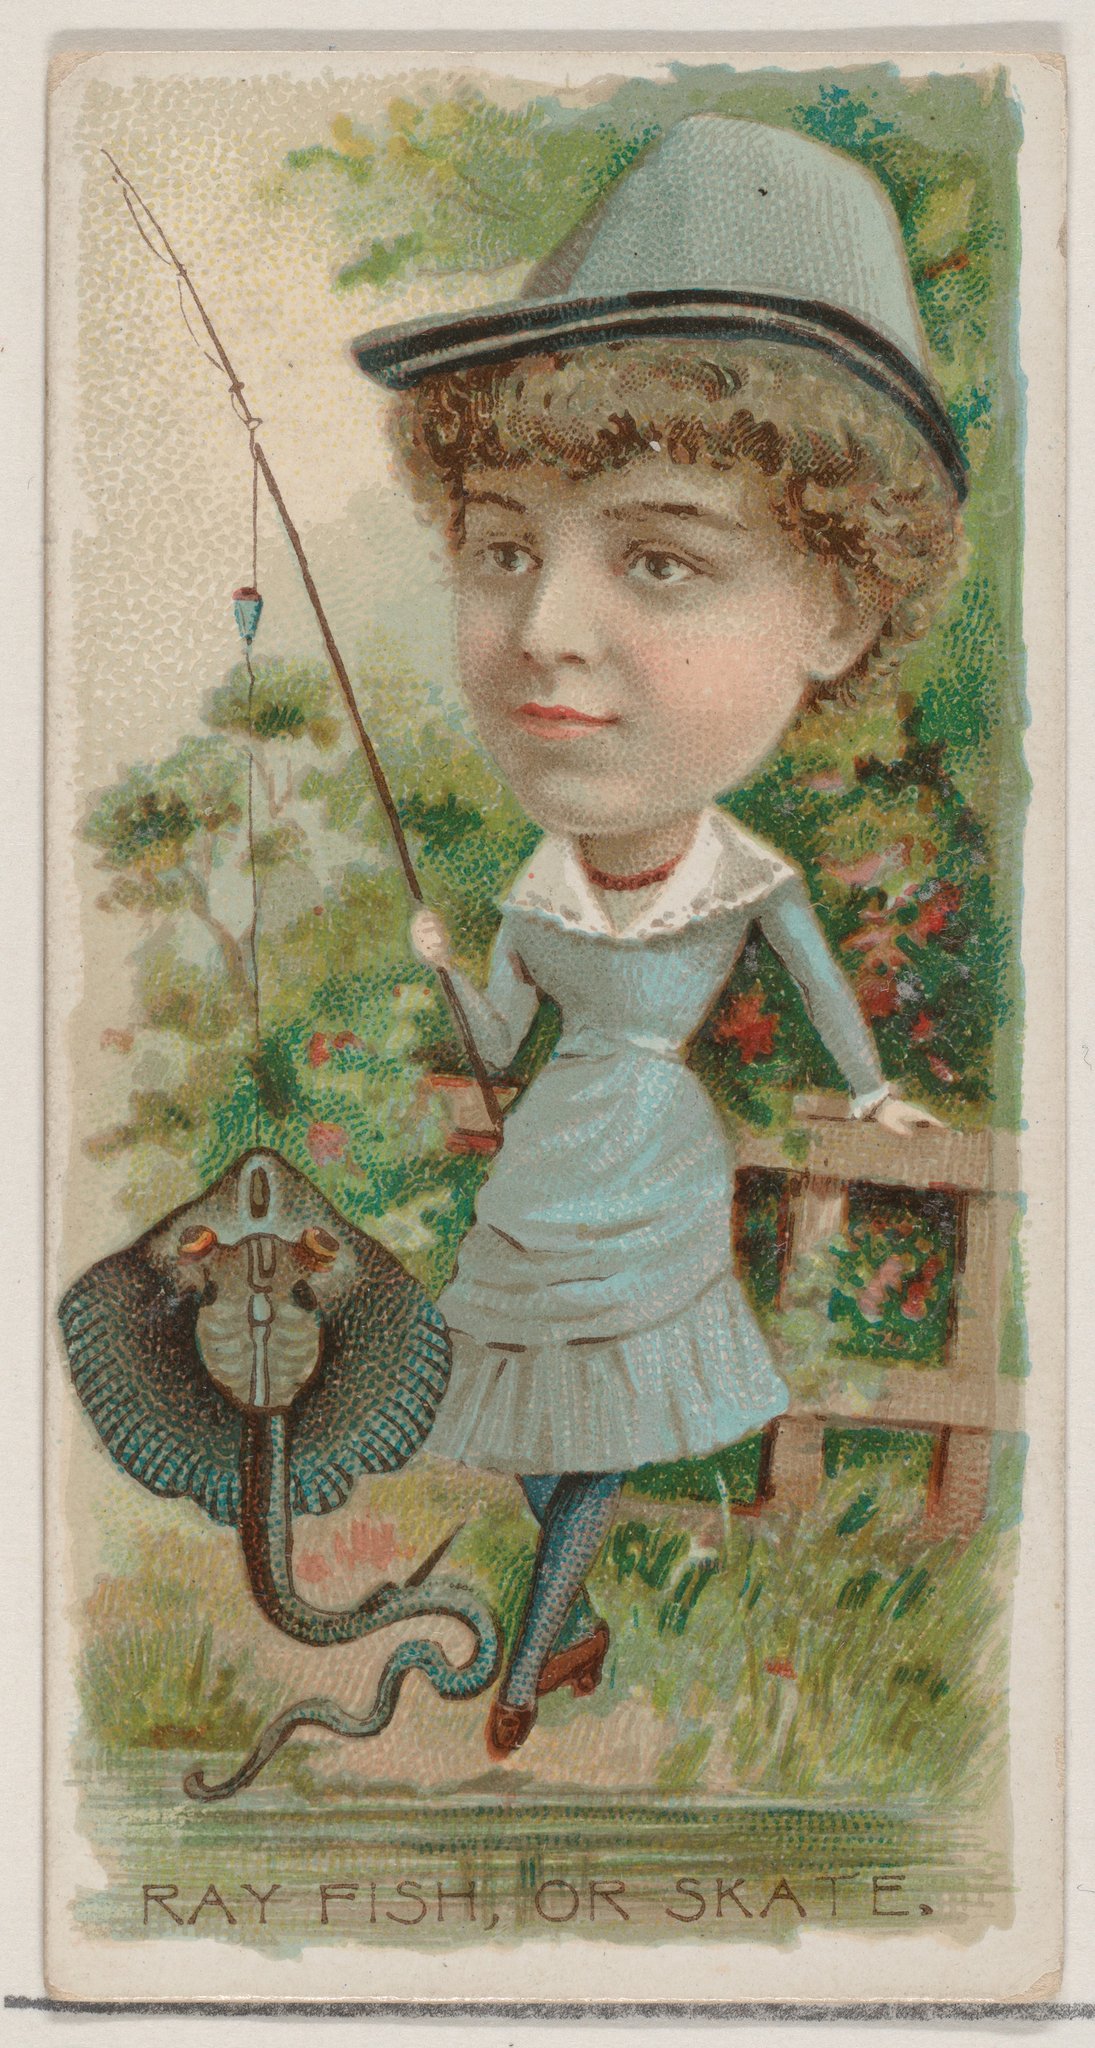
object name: print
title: Ray Fish, or Skate, from the series Fishers and Fish (N74) for Duke brand cigarettes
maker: knapp & company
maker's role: lithographer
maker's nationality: american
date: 1888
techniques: color lithograph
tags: women,fishing,fish